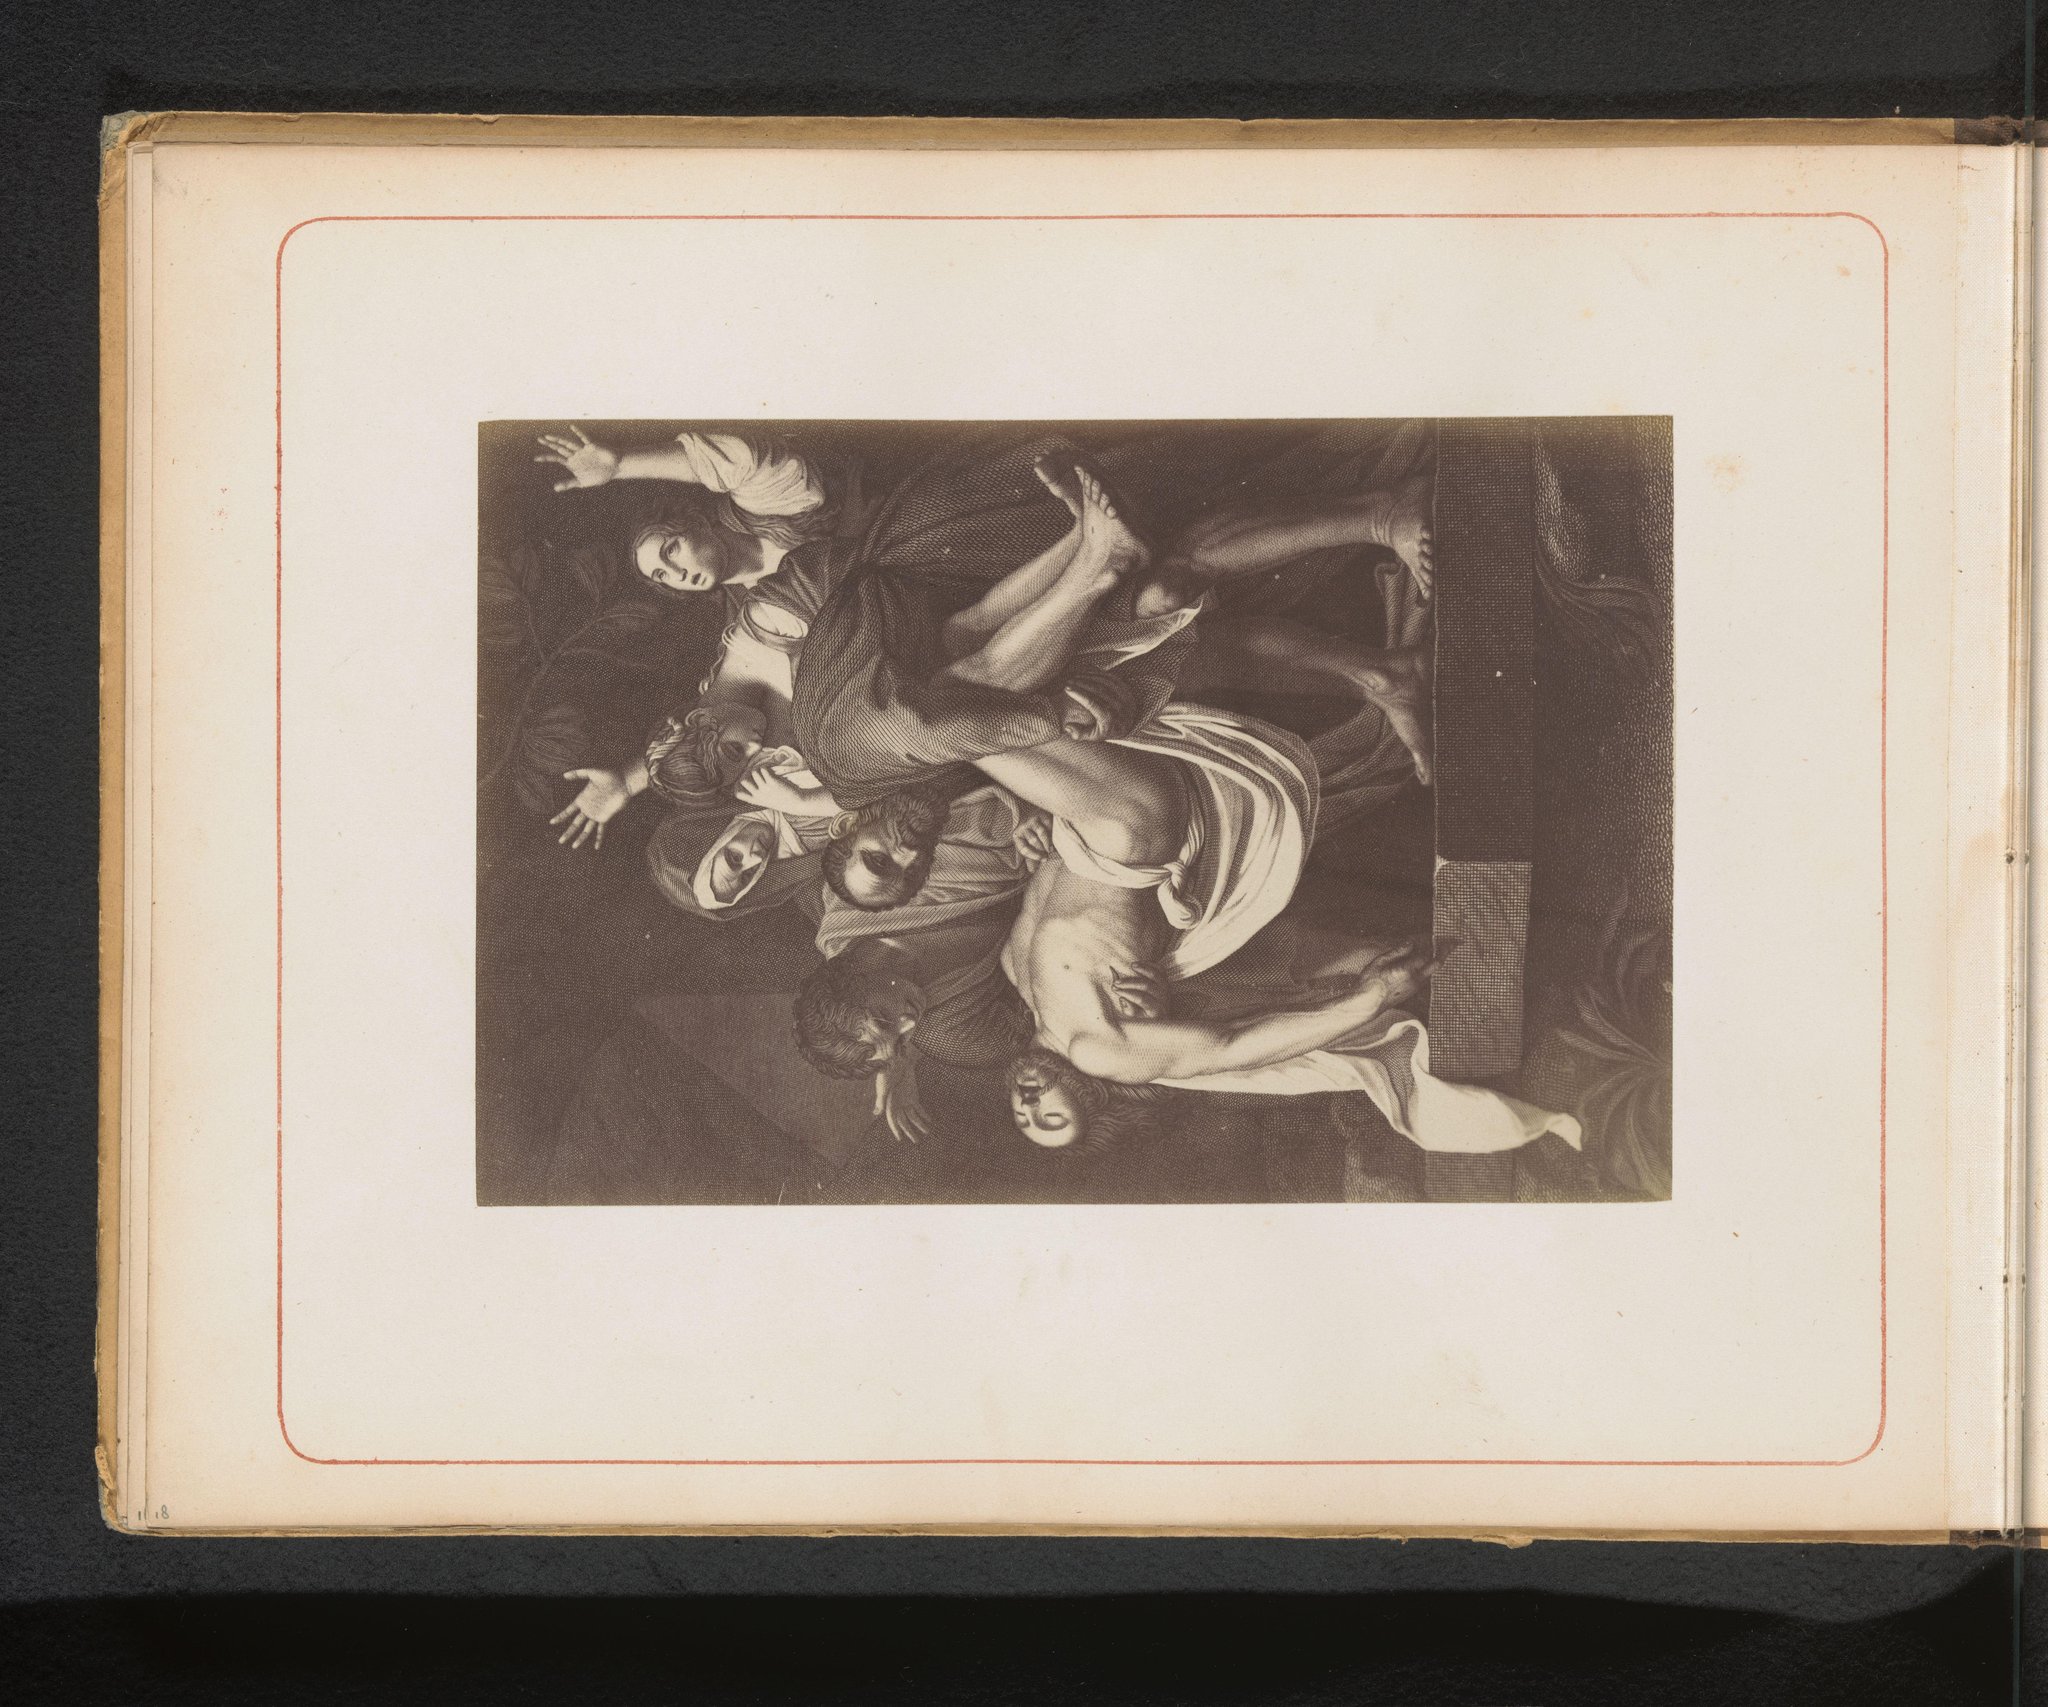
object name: page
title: Fotoreproductie van een gravure naar De kruisaflegging door Caravaggio in het Vaticaan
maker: Anonymous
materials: photographic support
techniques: albumen print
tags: descent from the cross: christ is taken down from the cross, usually by nicodemus and joseph of arimathaea who are standing on the ladders (both arms of christ detached)